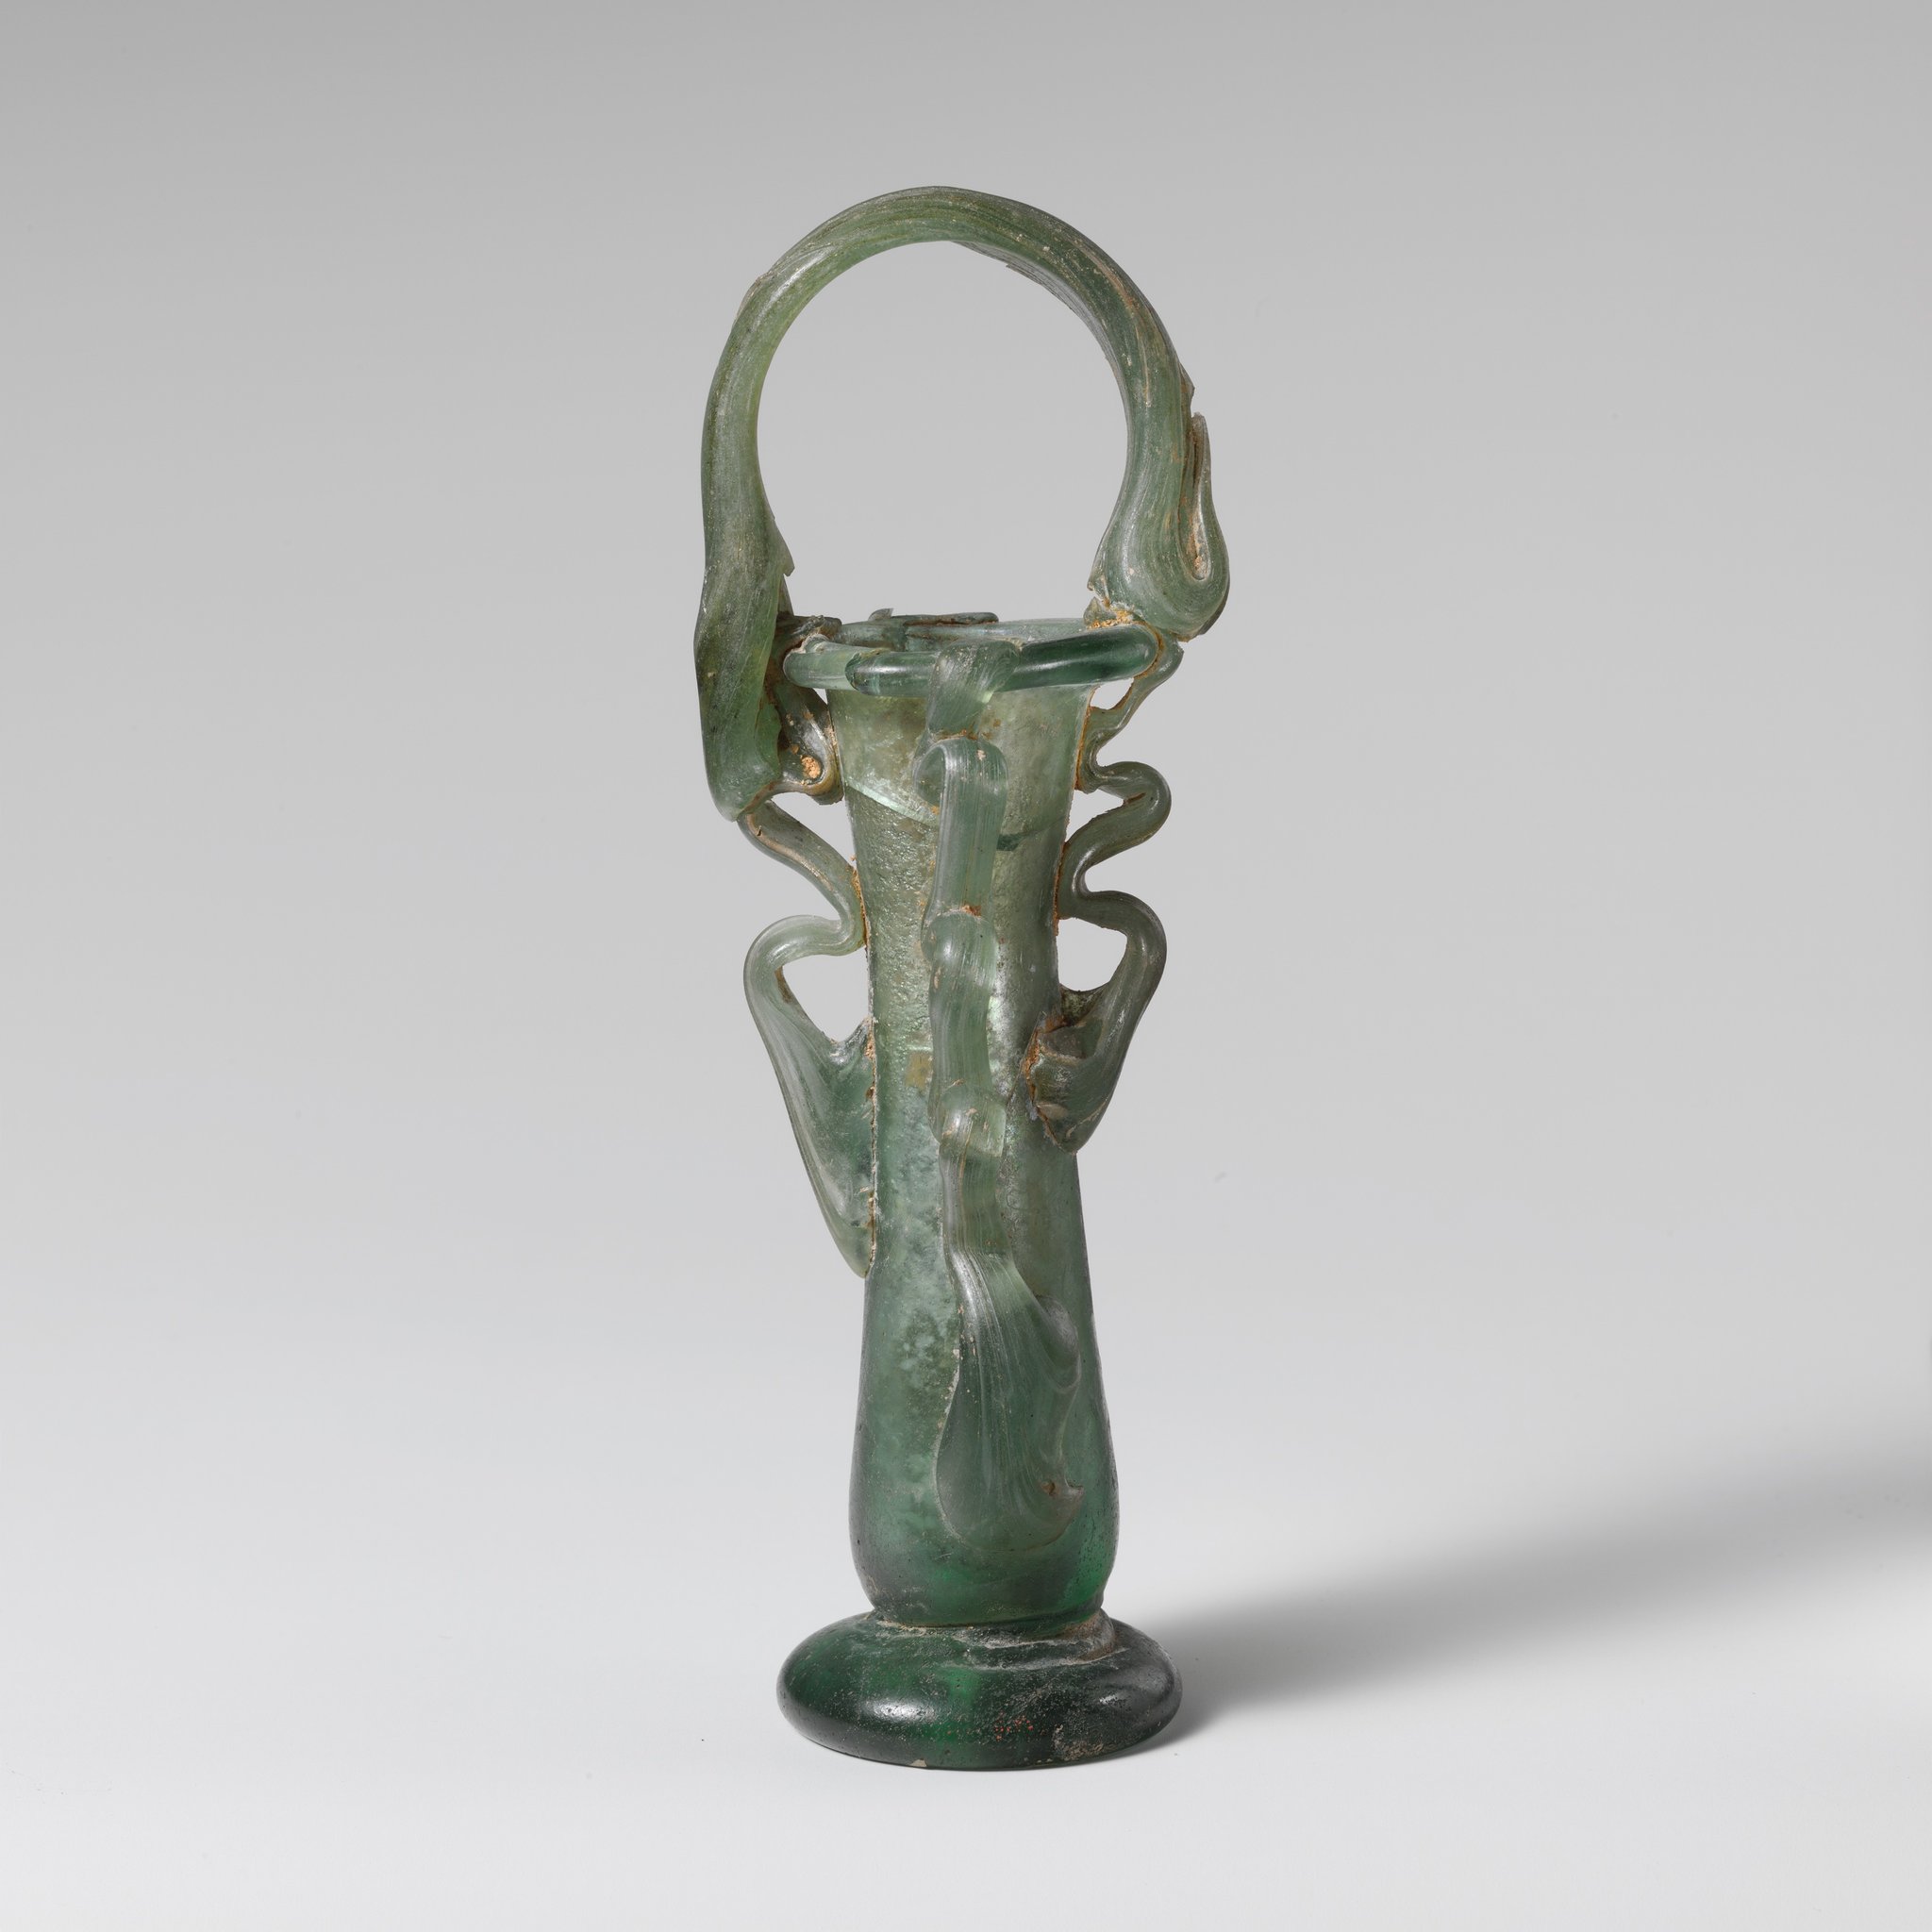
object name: cosmetic flask, single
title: Glass cosmetic flask (kohl tube)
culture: roman, syrian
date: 301-400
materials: glass